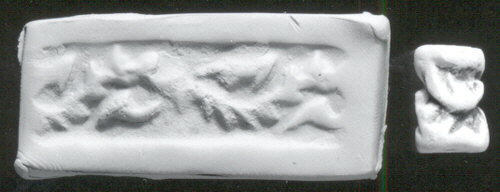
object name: cylinder seal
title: Cylinder seal with geometric design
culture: iranian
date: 1000-1 BCE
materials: faience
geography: iran